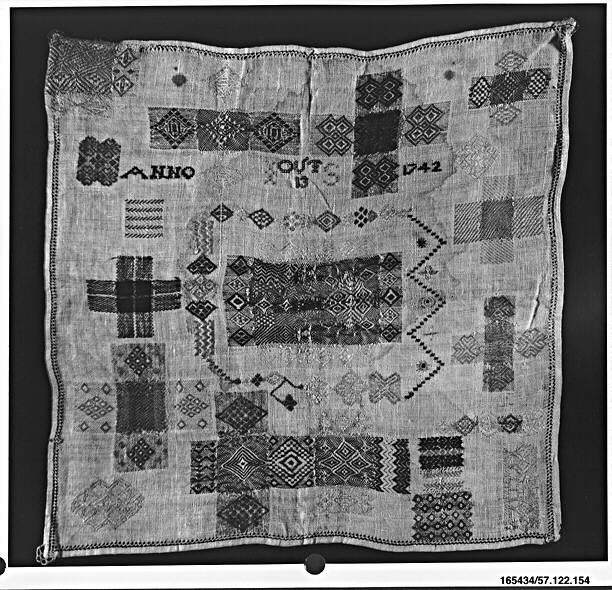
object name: sampler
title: Embroidered darning sampler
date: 1742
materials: linen, silk